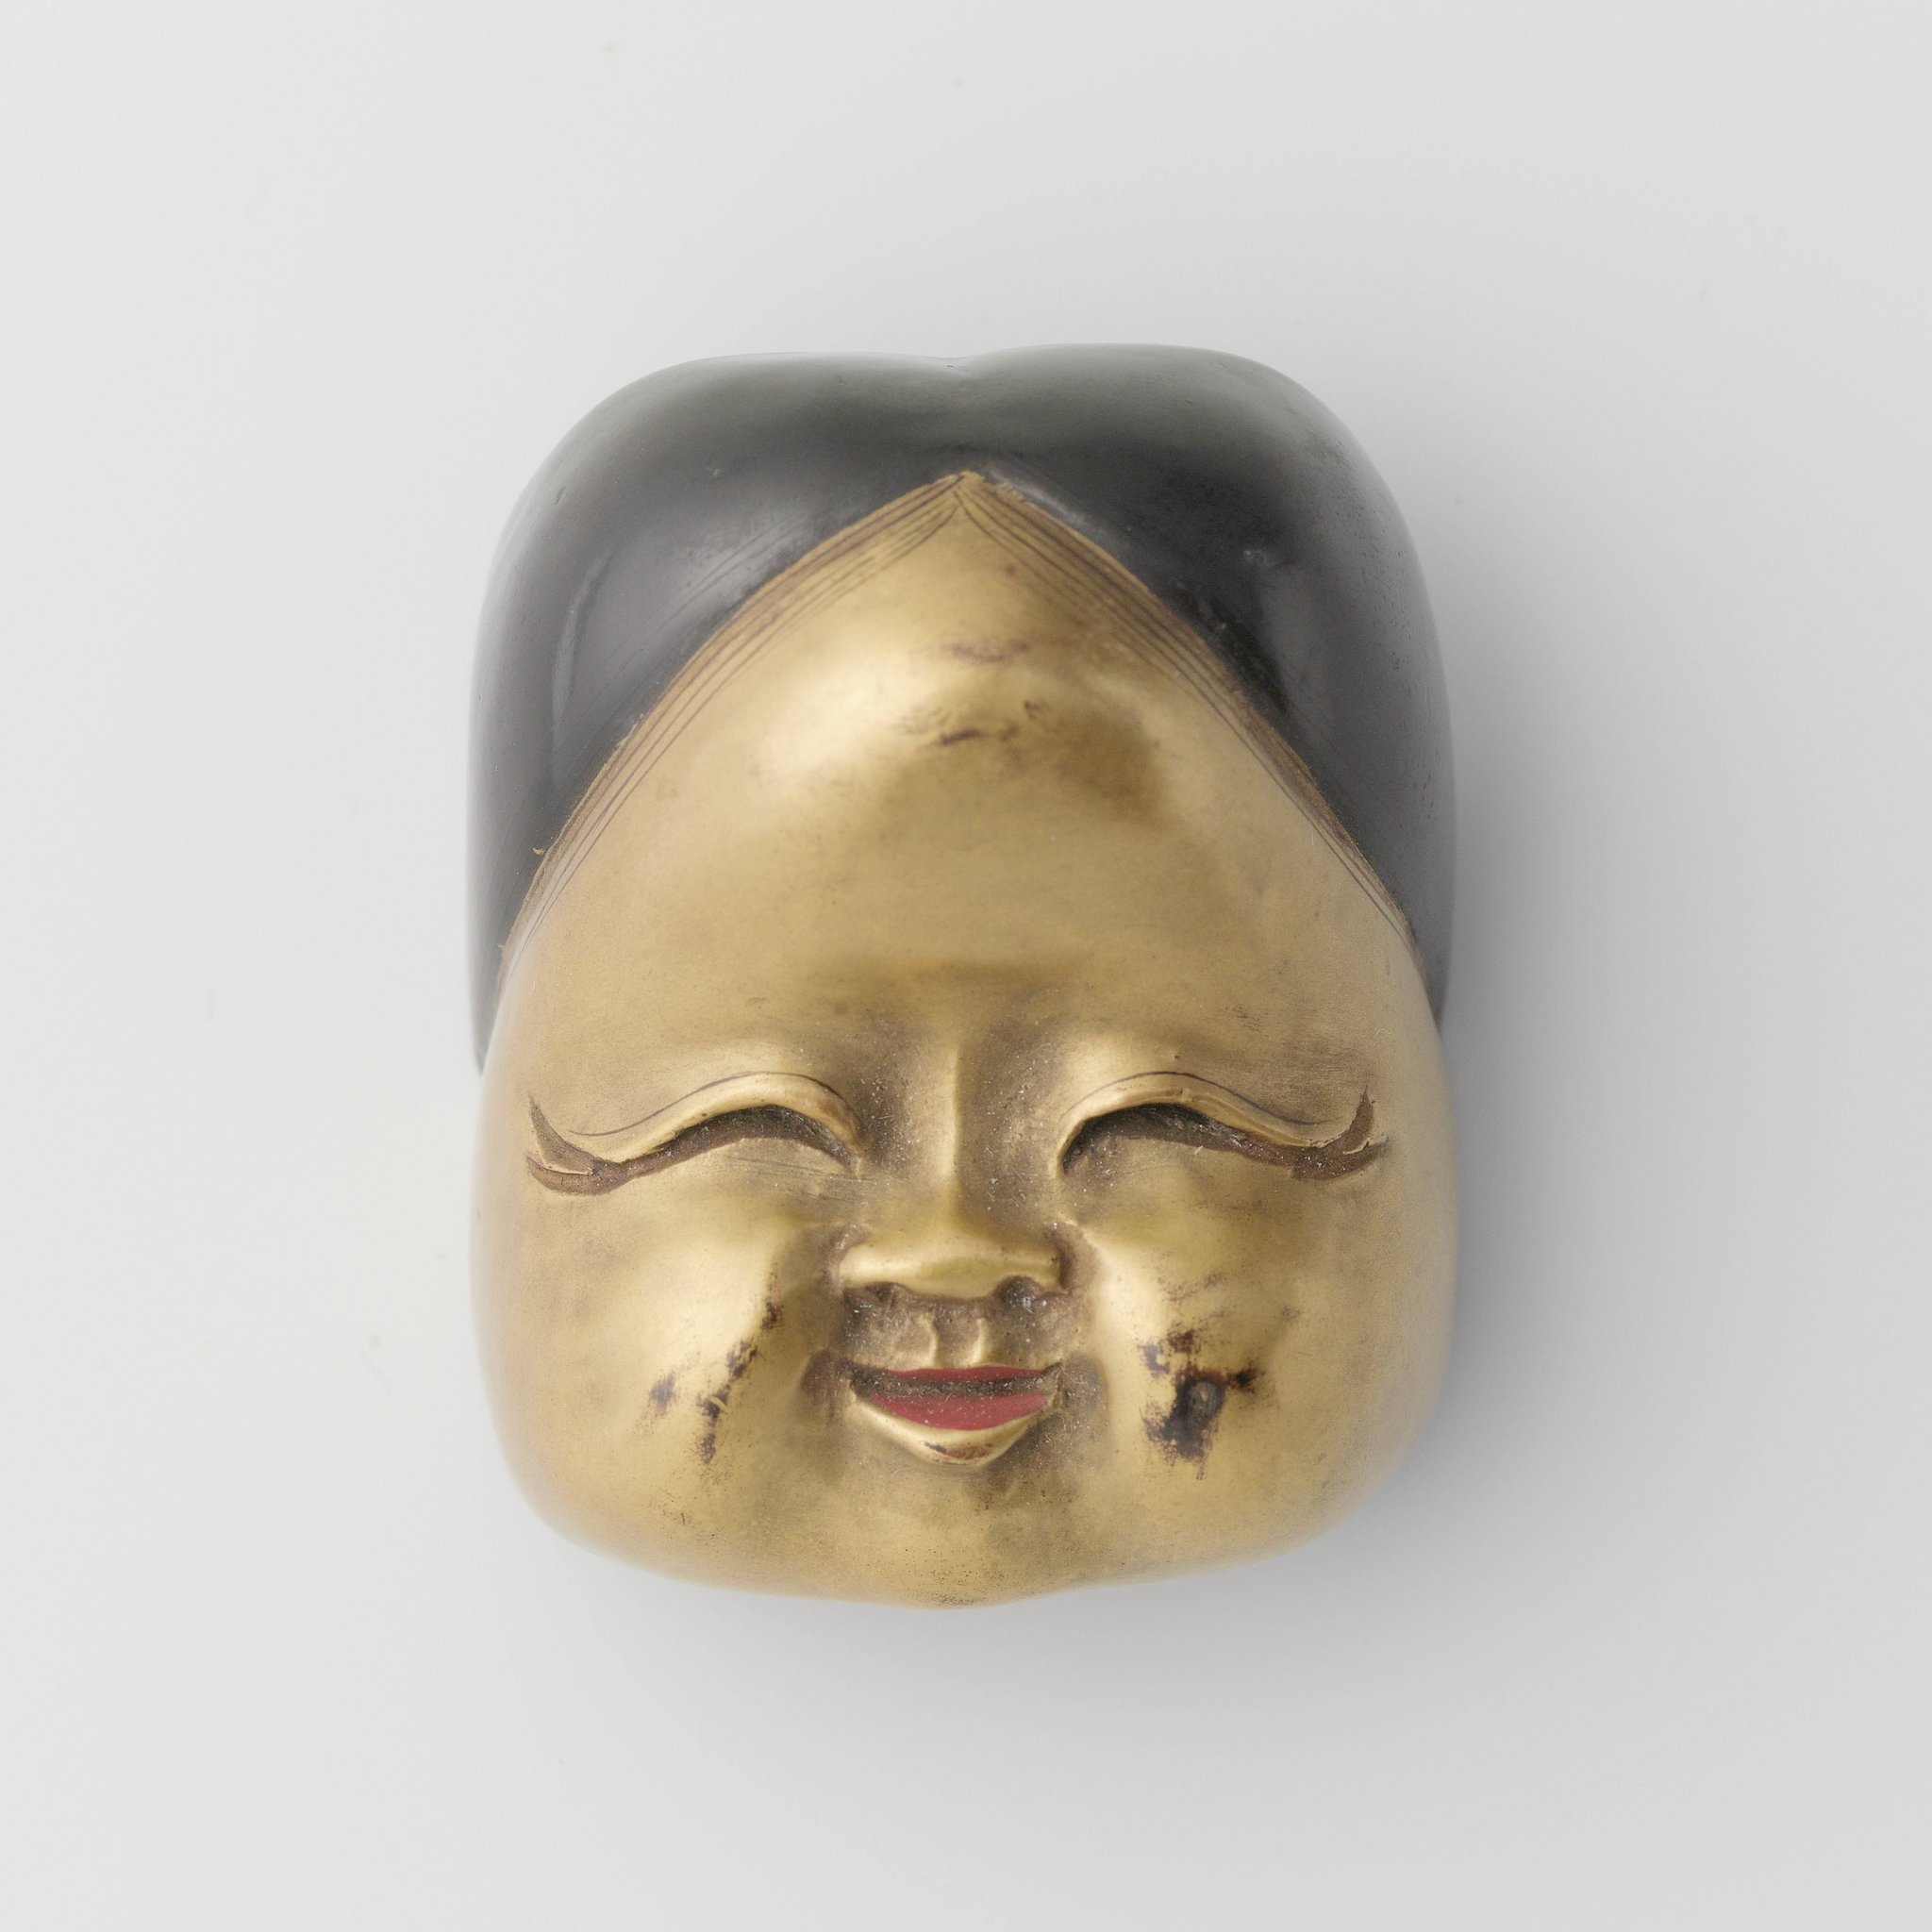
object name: netsuke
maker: tomomasa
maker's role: houtsnijder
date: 1800-1850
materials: lacquer, wood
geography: japan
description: Masker van Okame, het lelijke meisje. Gesigneerd "tomomasa".